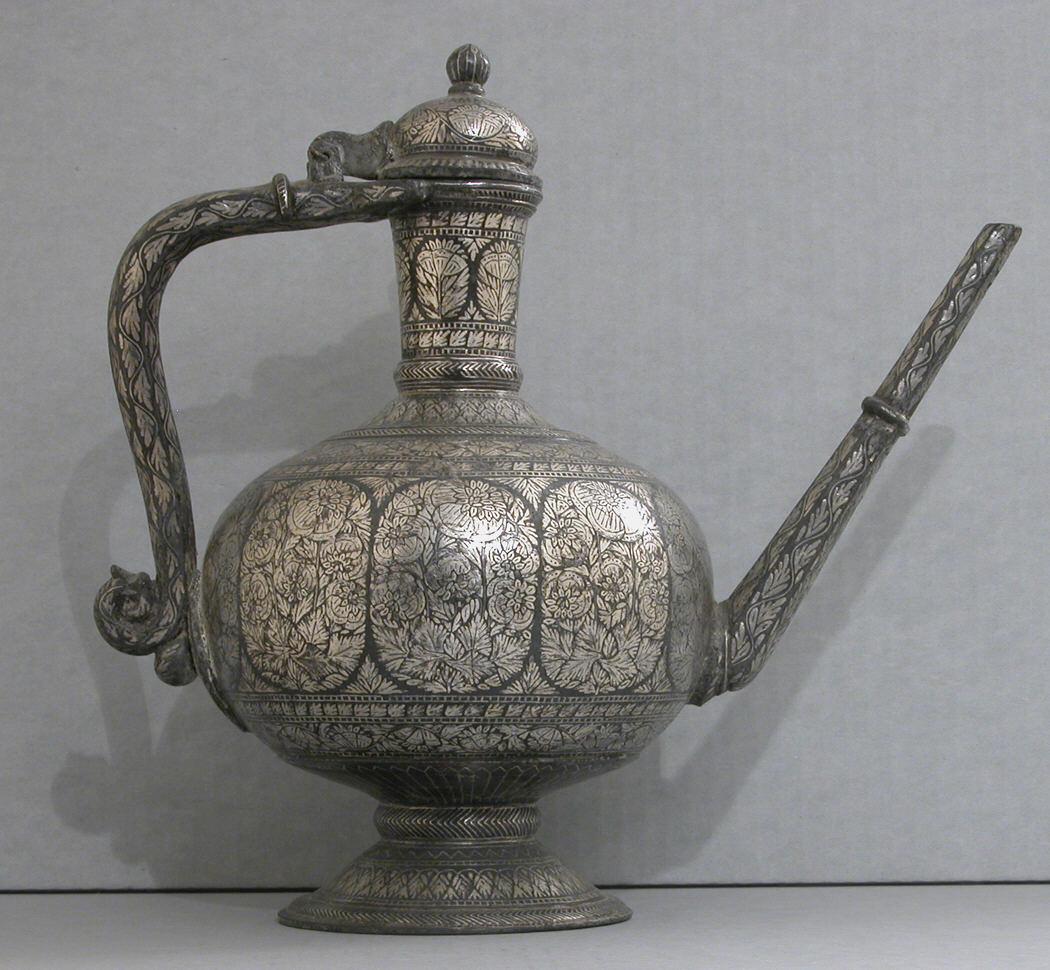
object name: ewer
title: Globular Ewer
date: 1701-1800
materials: copper alloy, silver, zinc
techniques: casting, engraving, inlay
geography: india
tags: flowers,leaves